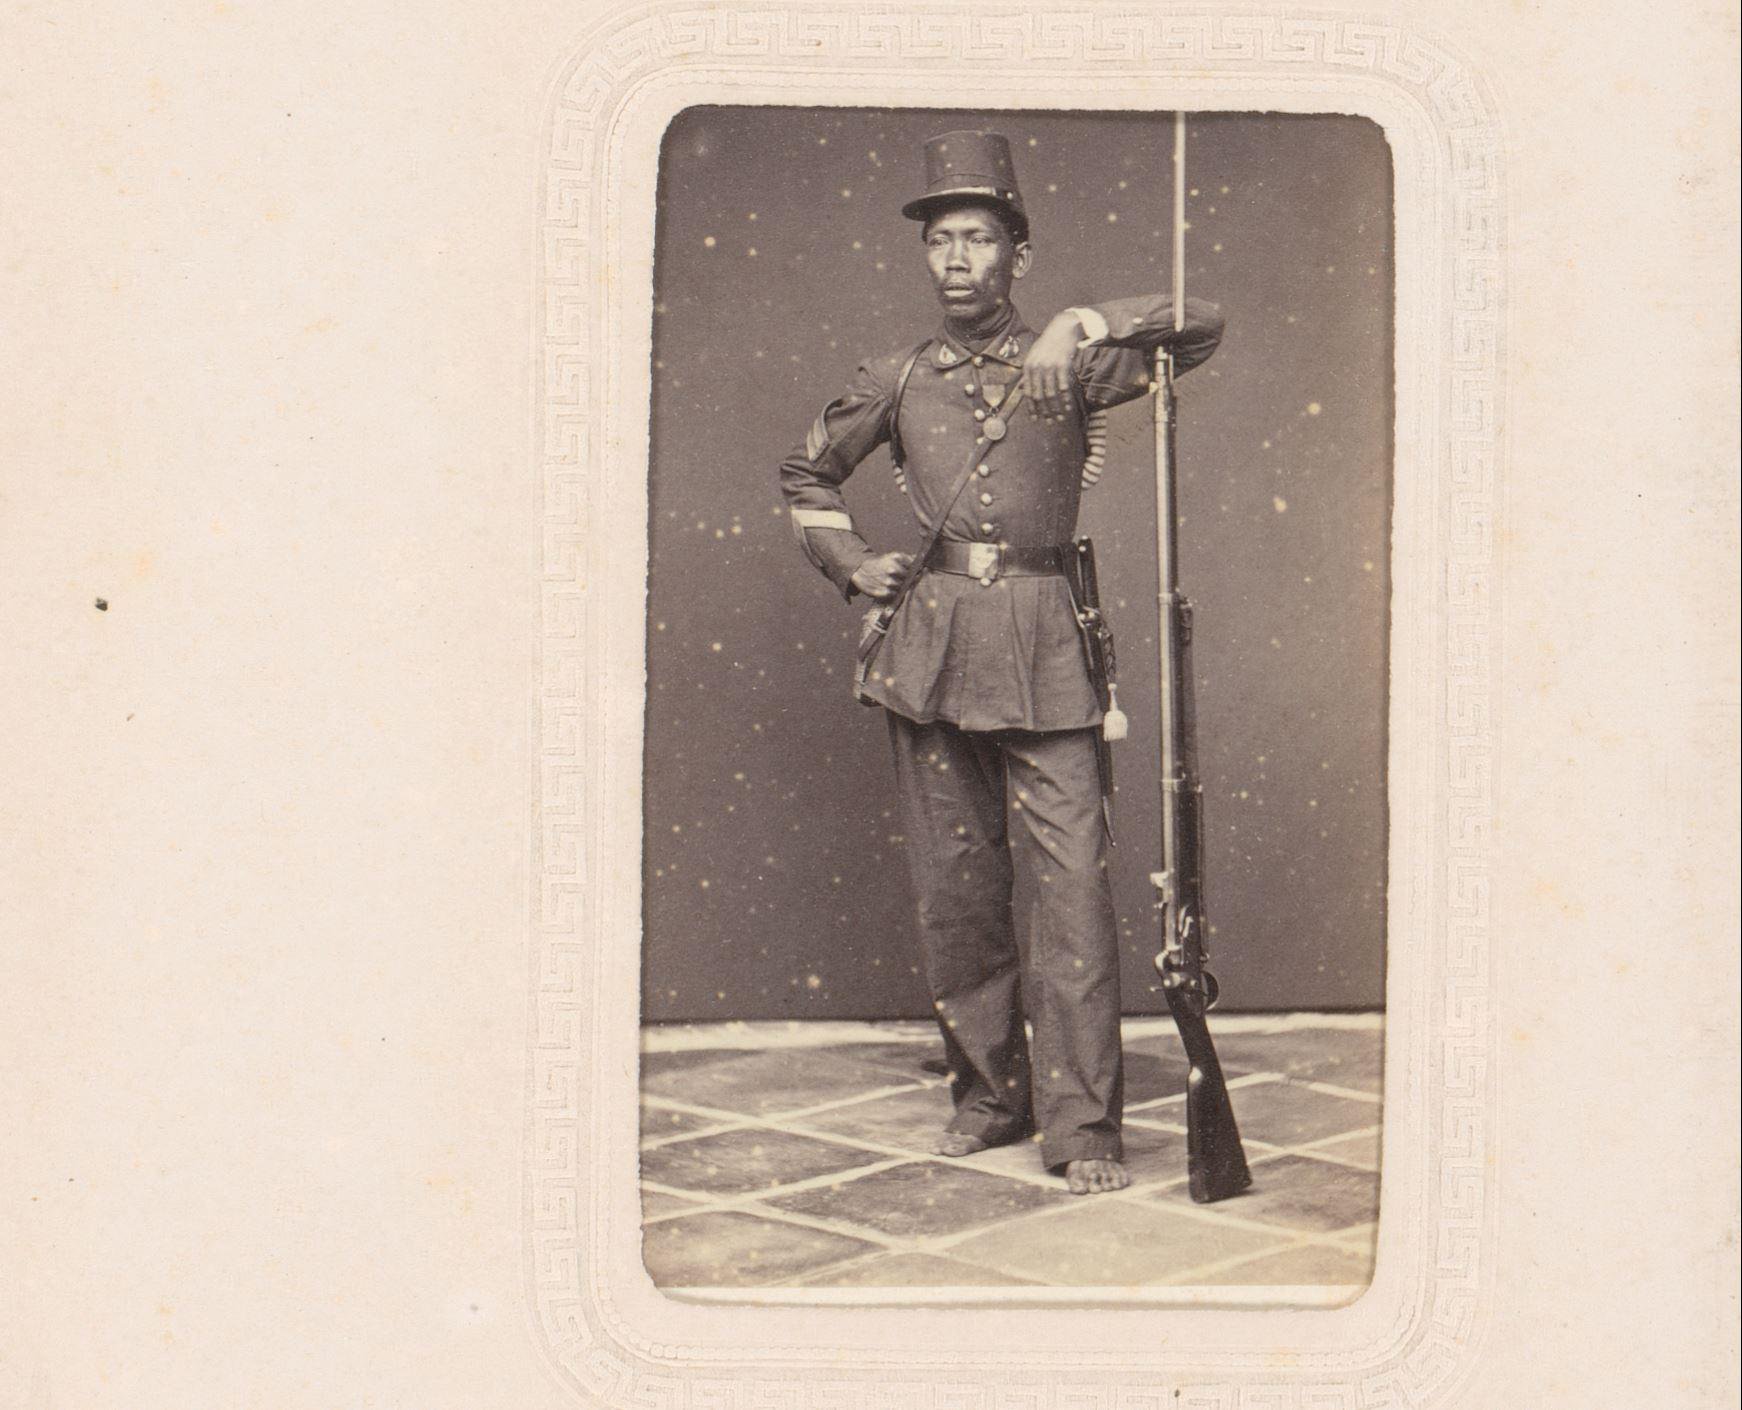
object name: photograph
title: Portret van een Indonesische soldaat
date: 1857-1880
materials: cardboard, photographic support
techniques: albumen print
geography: java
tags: historical persons, (military) uniforms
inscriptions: inscription: ‘Woodbury & Page/ Photographers/ Java’, number: ‘104’